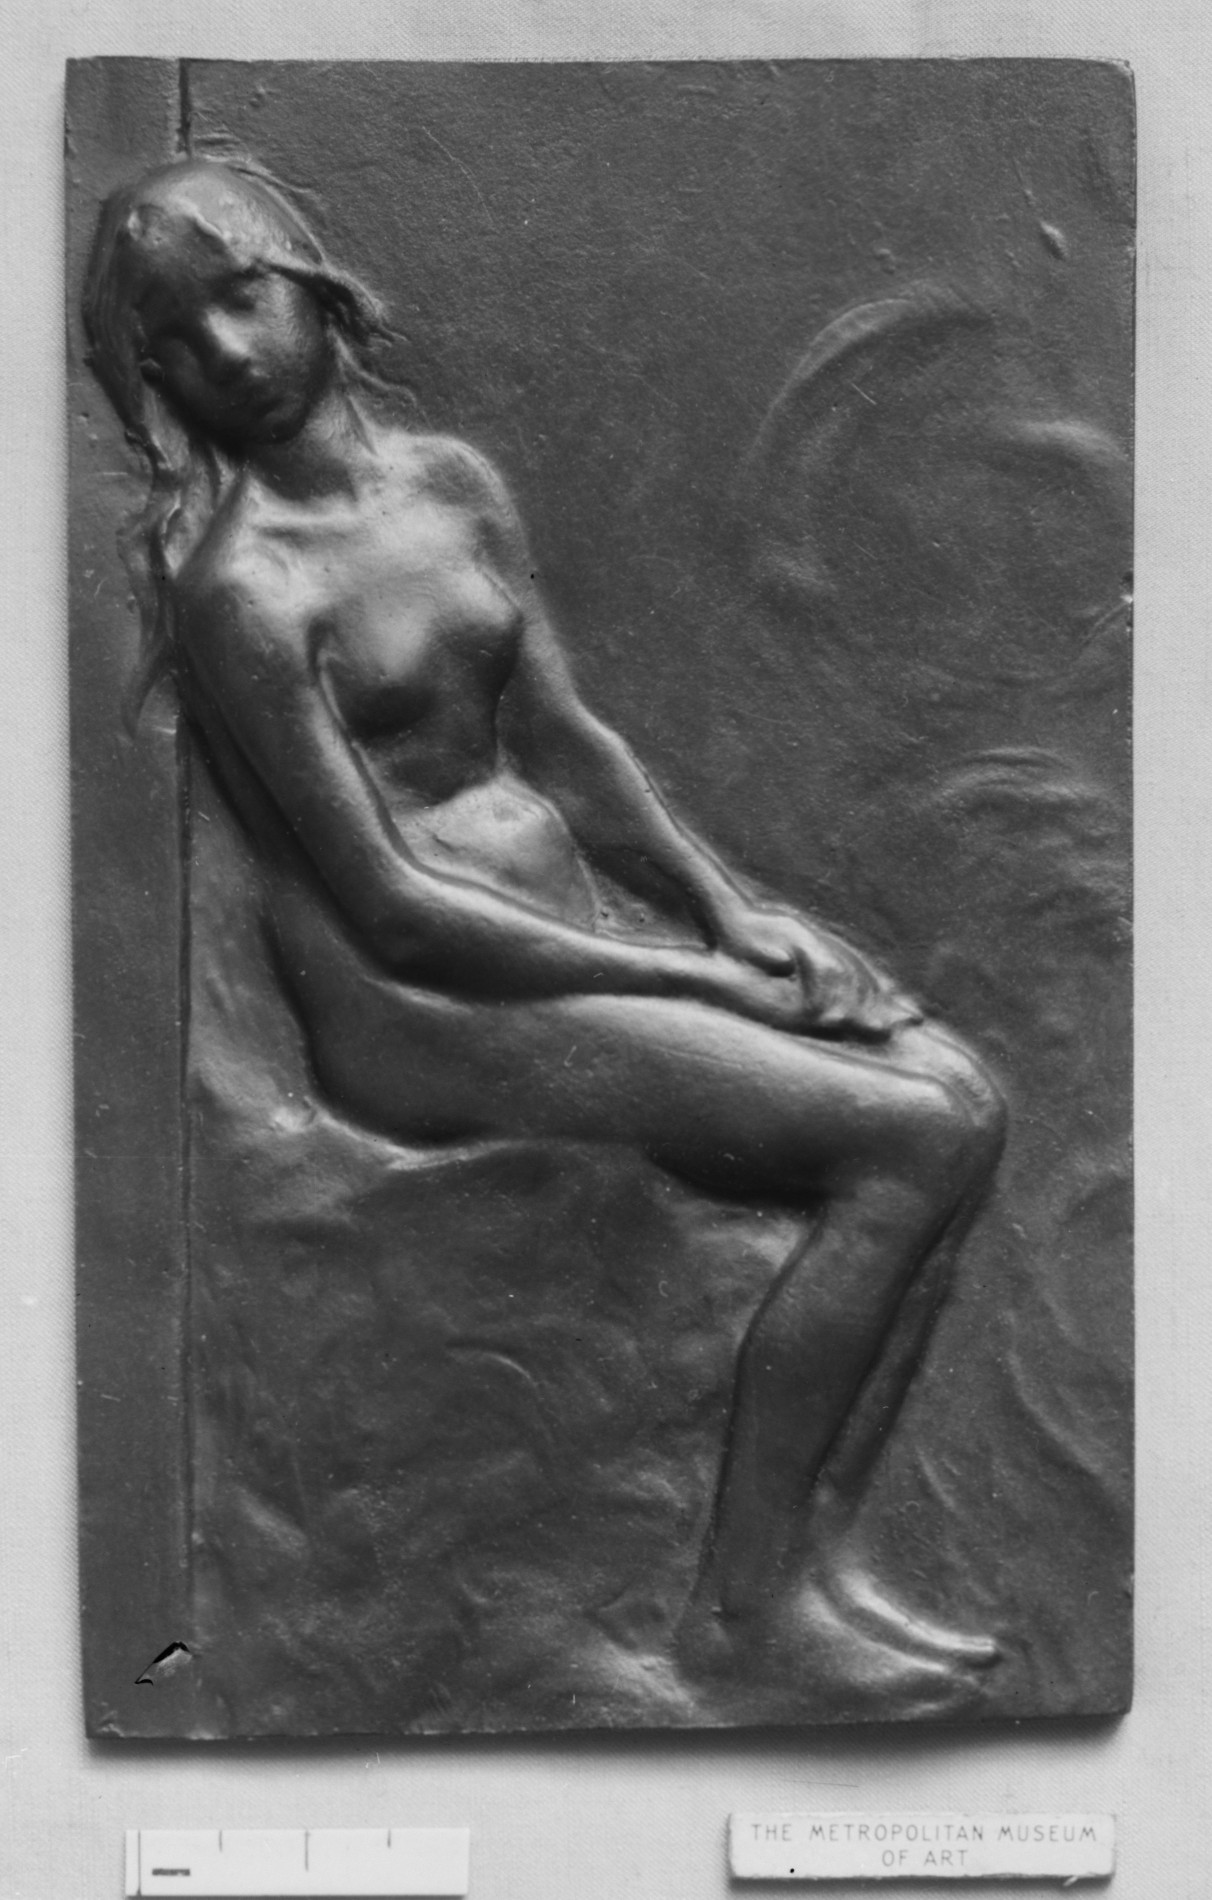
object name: plaquette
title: Known as "Sleep"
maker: alexandre-louis-marie charpentier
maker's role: artist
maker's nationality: french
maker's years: 1856-1909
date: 1867-1900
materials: bronze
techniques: casting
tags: sleeping,female nudes